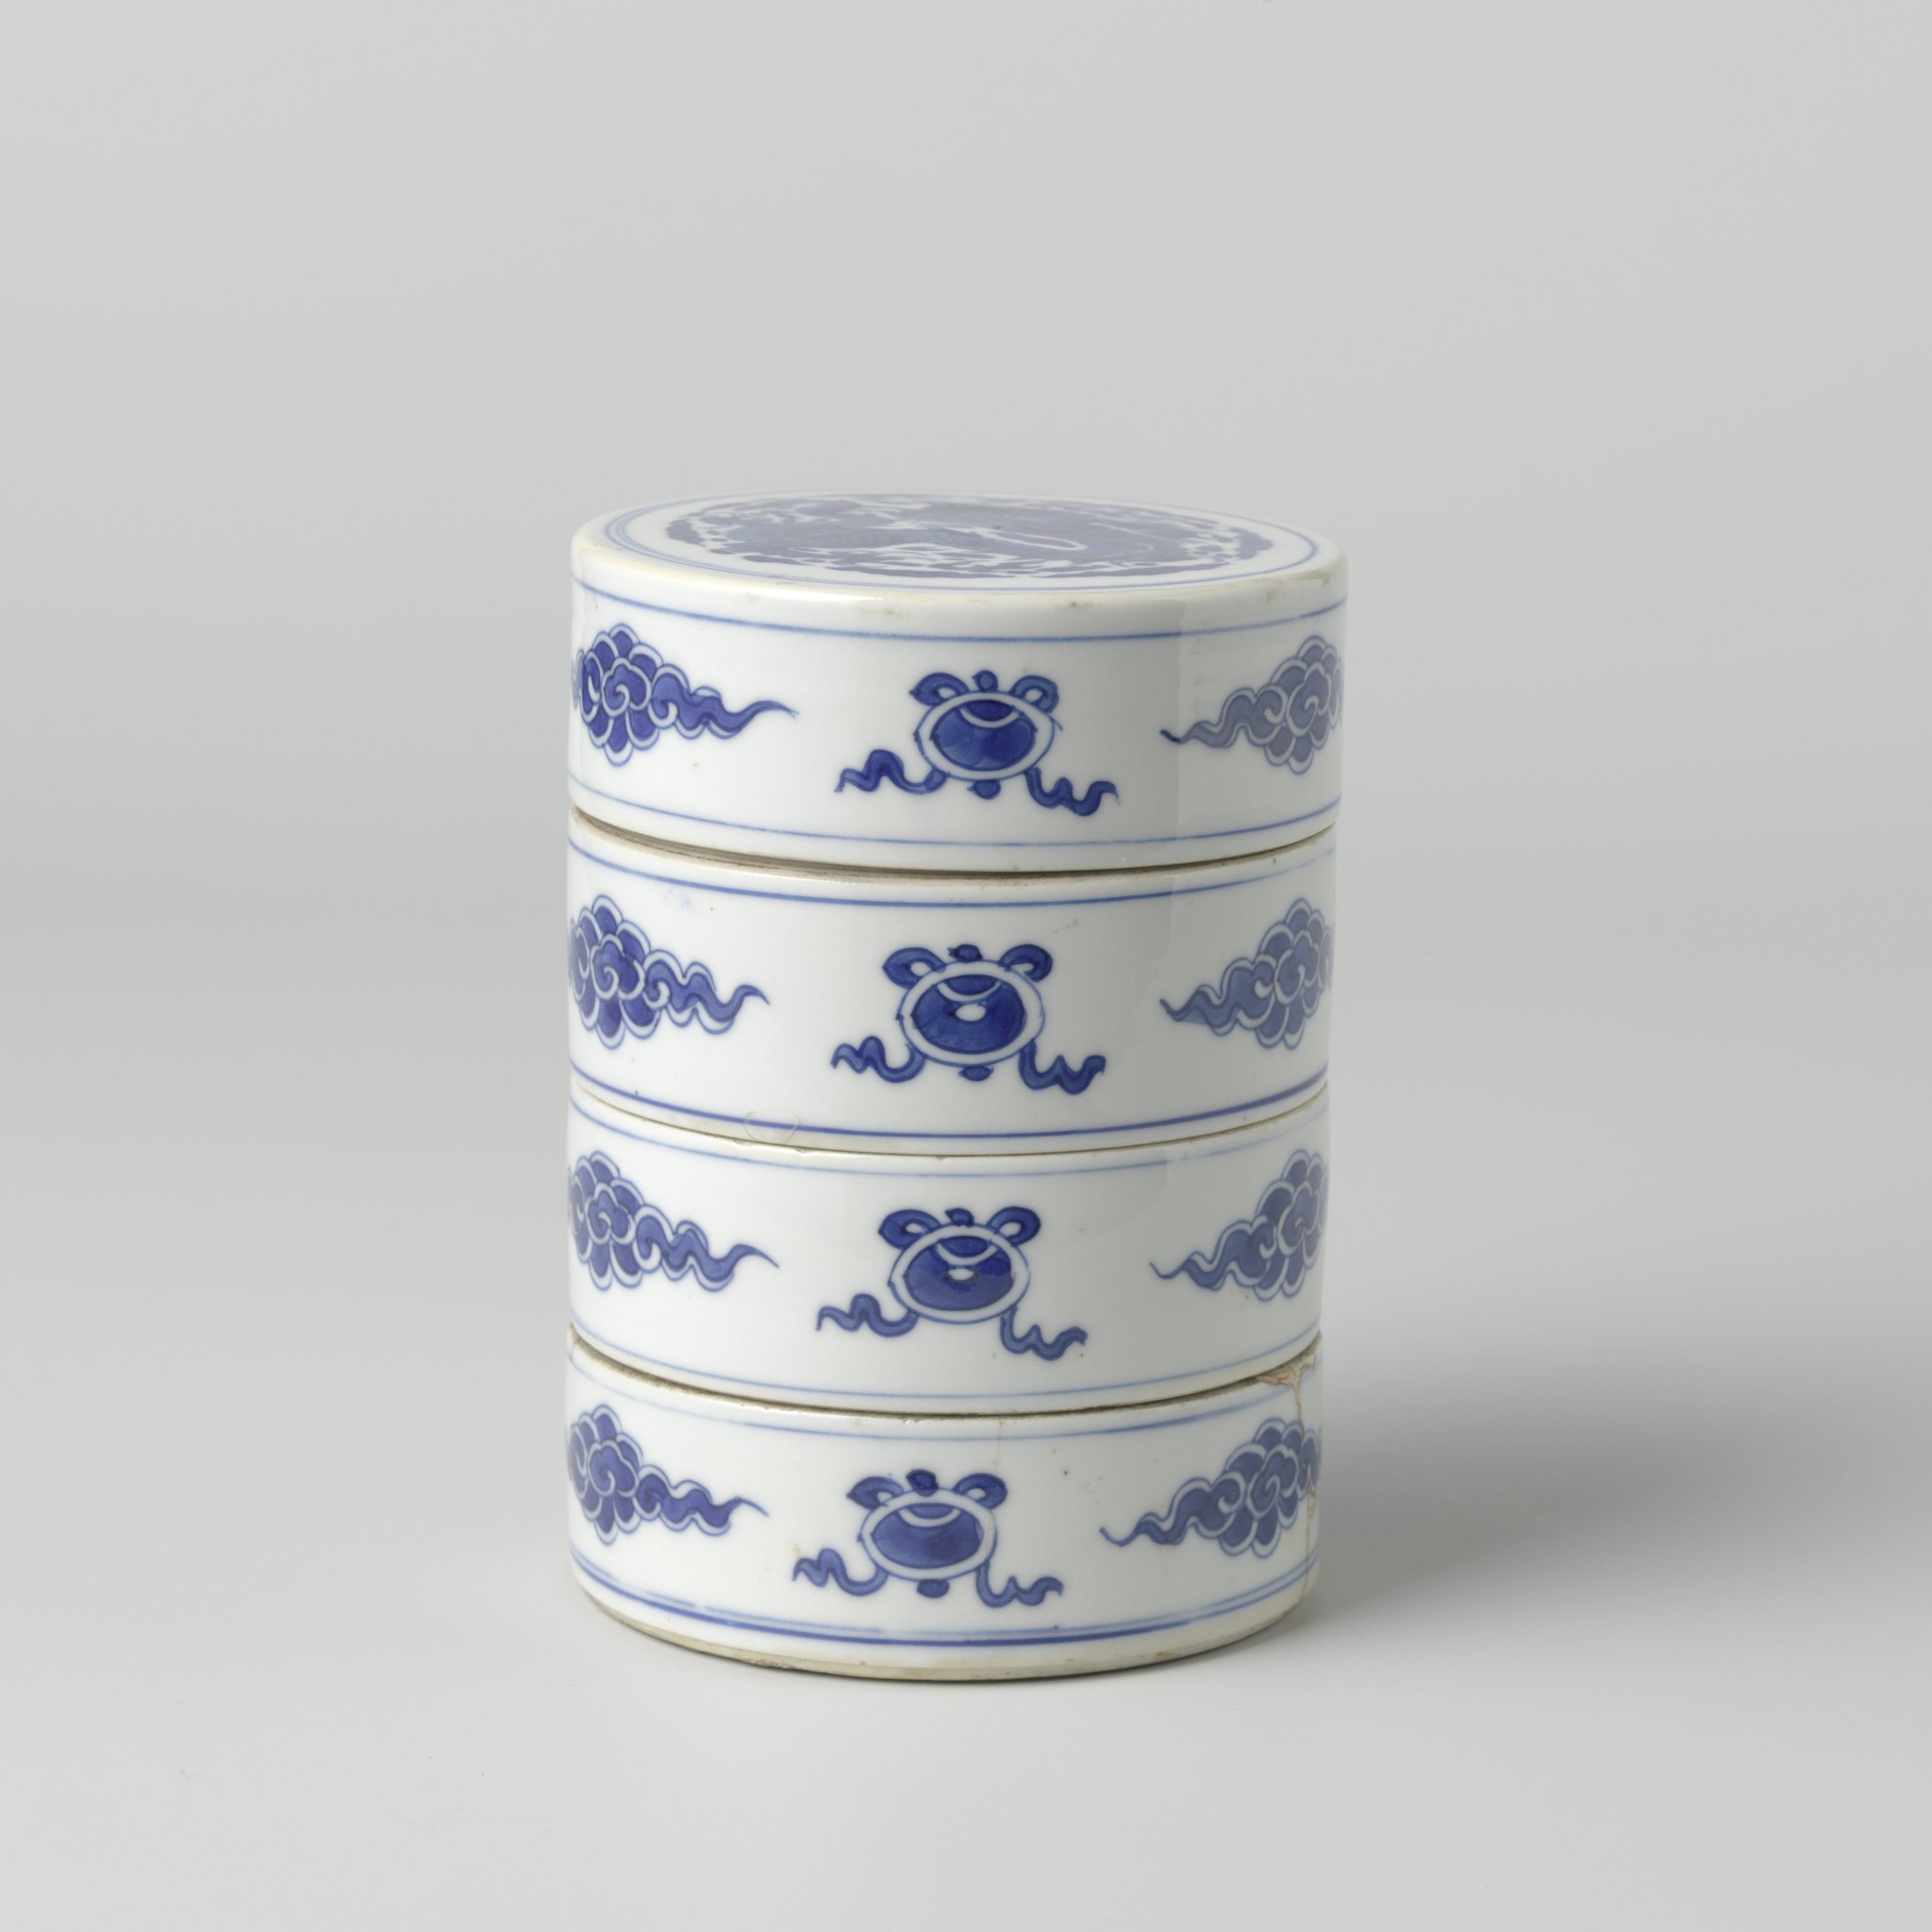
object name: stapeldoos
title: Tiered box composed of three layers with dragon en precious objects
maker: Anonymous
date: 1680-1720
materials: cobalt, glaze, paint, porcelain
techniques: firing, turning, vitrification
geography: china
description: Ronde stapeldoos van porselein bestaande uit drie lagen en een deksel, beschilderd in onderglazuur blauw. De wanden van de dozen en de deksel met wolkmotieven en kostbaarheden (parel, ruit, muzieksteen). Blauw-wit.